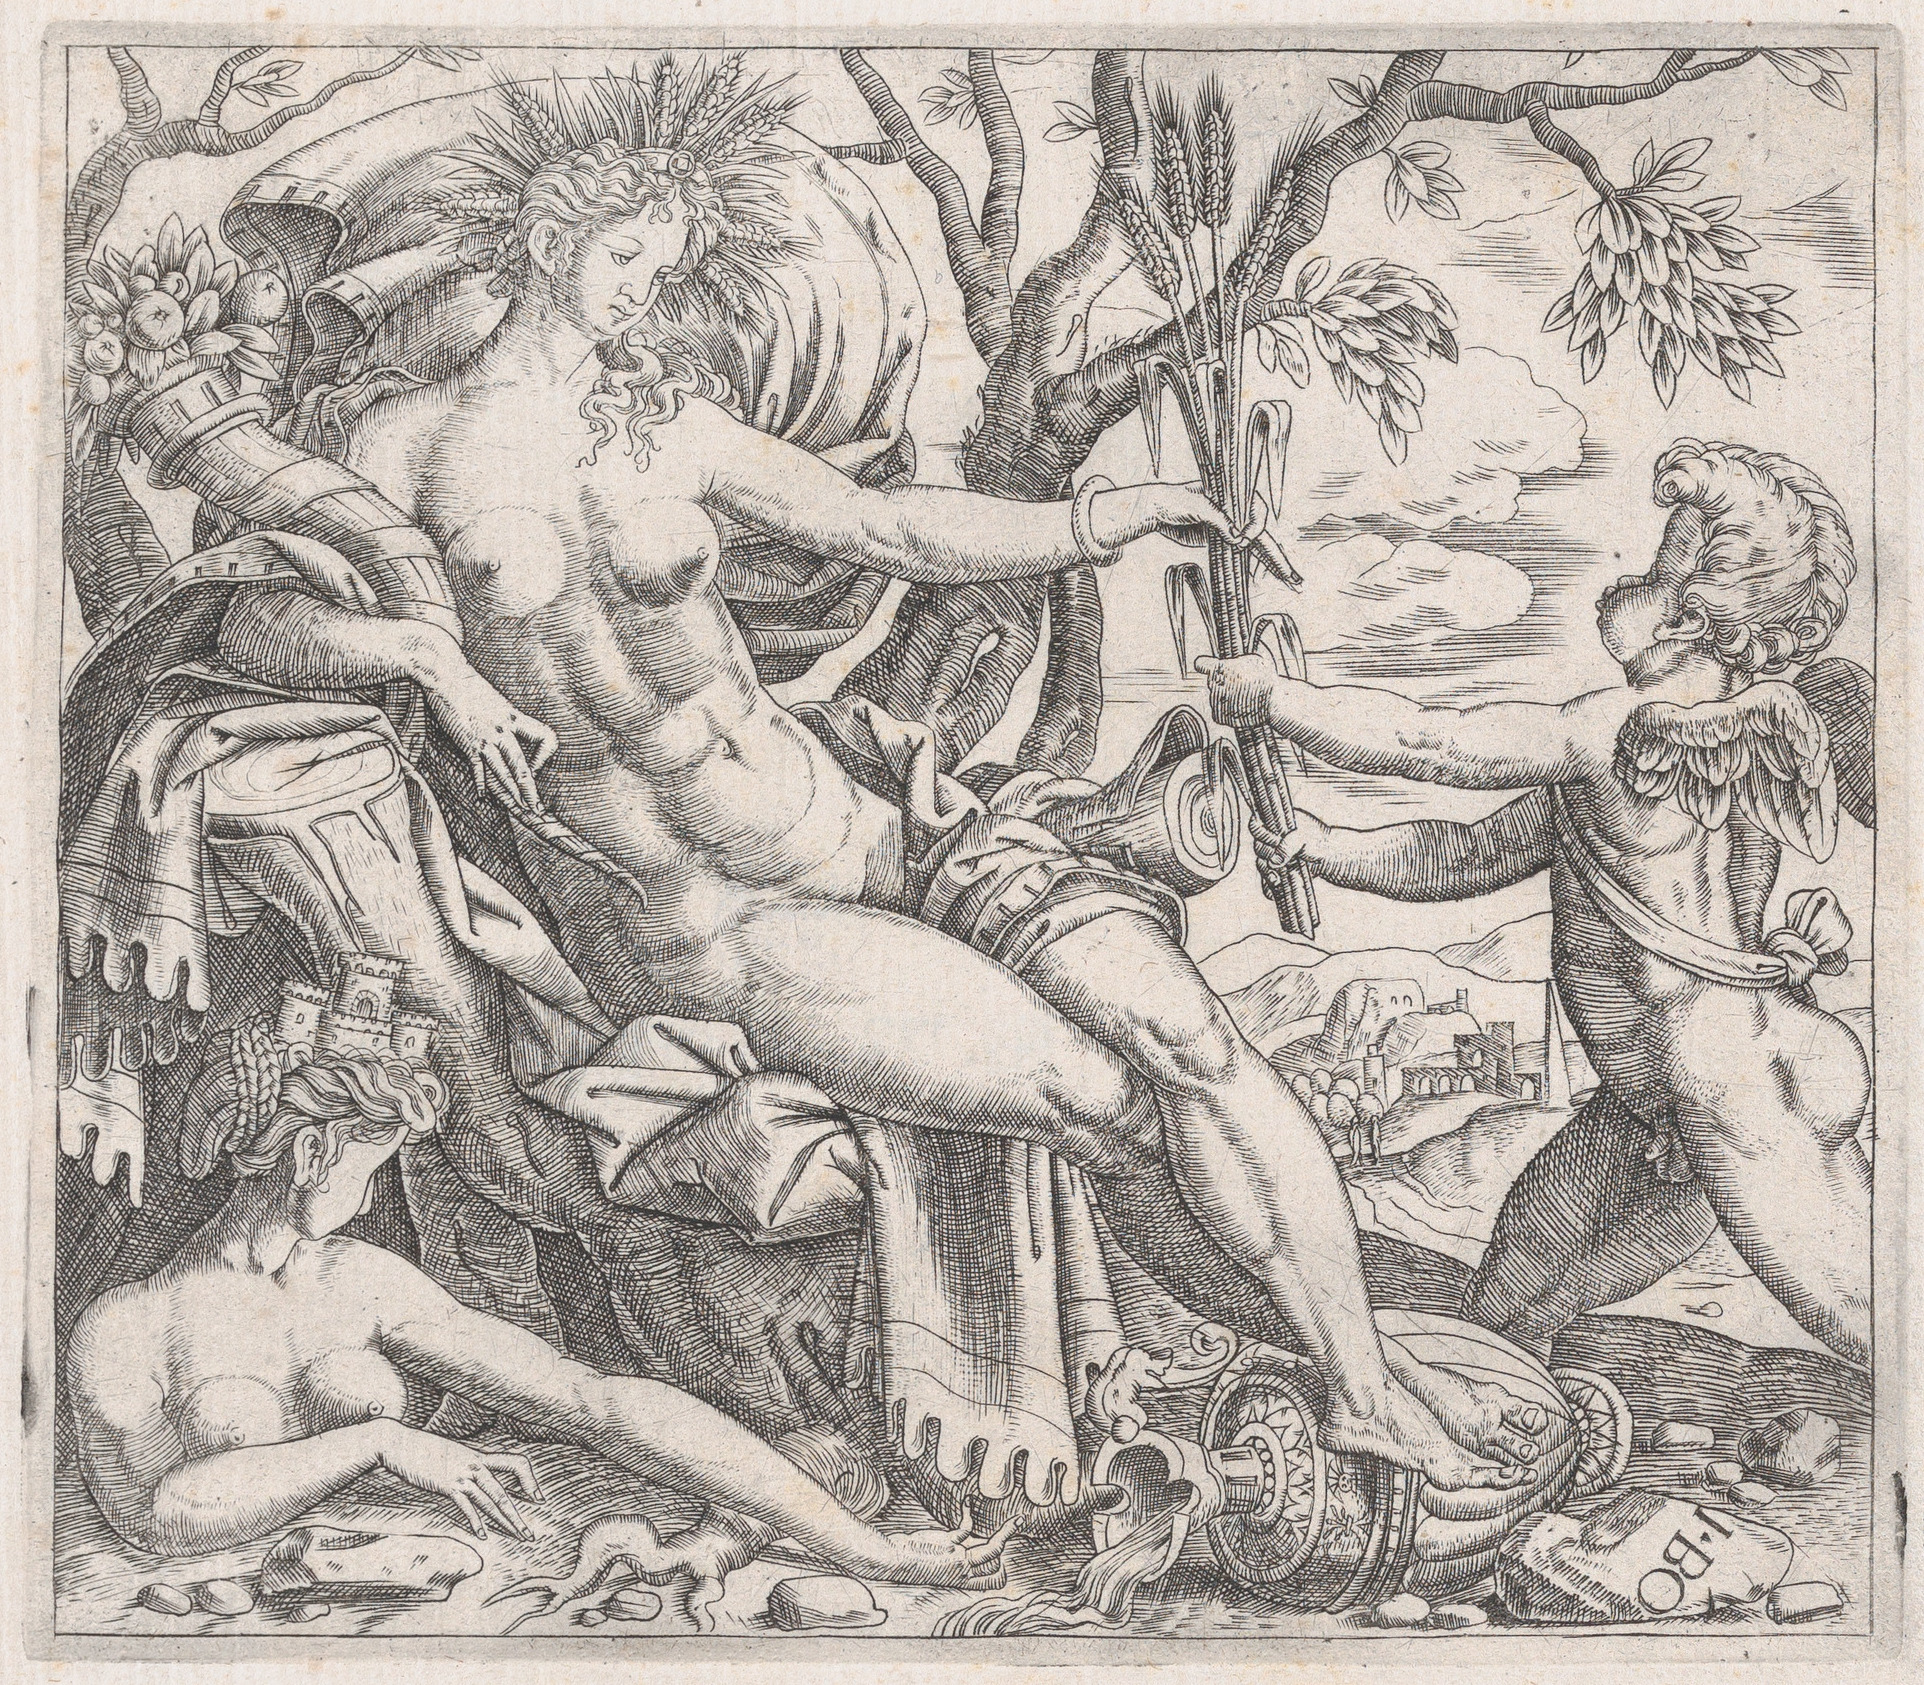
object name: print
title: A Putto Presenting Grain to Ceres, from "Speculum Romanae Magnificentiae"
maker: Anonymous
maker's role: artist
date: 1501-1600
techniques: etching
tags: putti,ceres,cornucopia